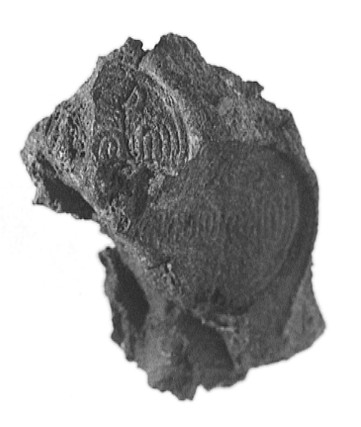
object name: sealing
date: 2030-1640 BCE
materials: clay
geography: egypt